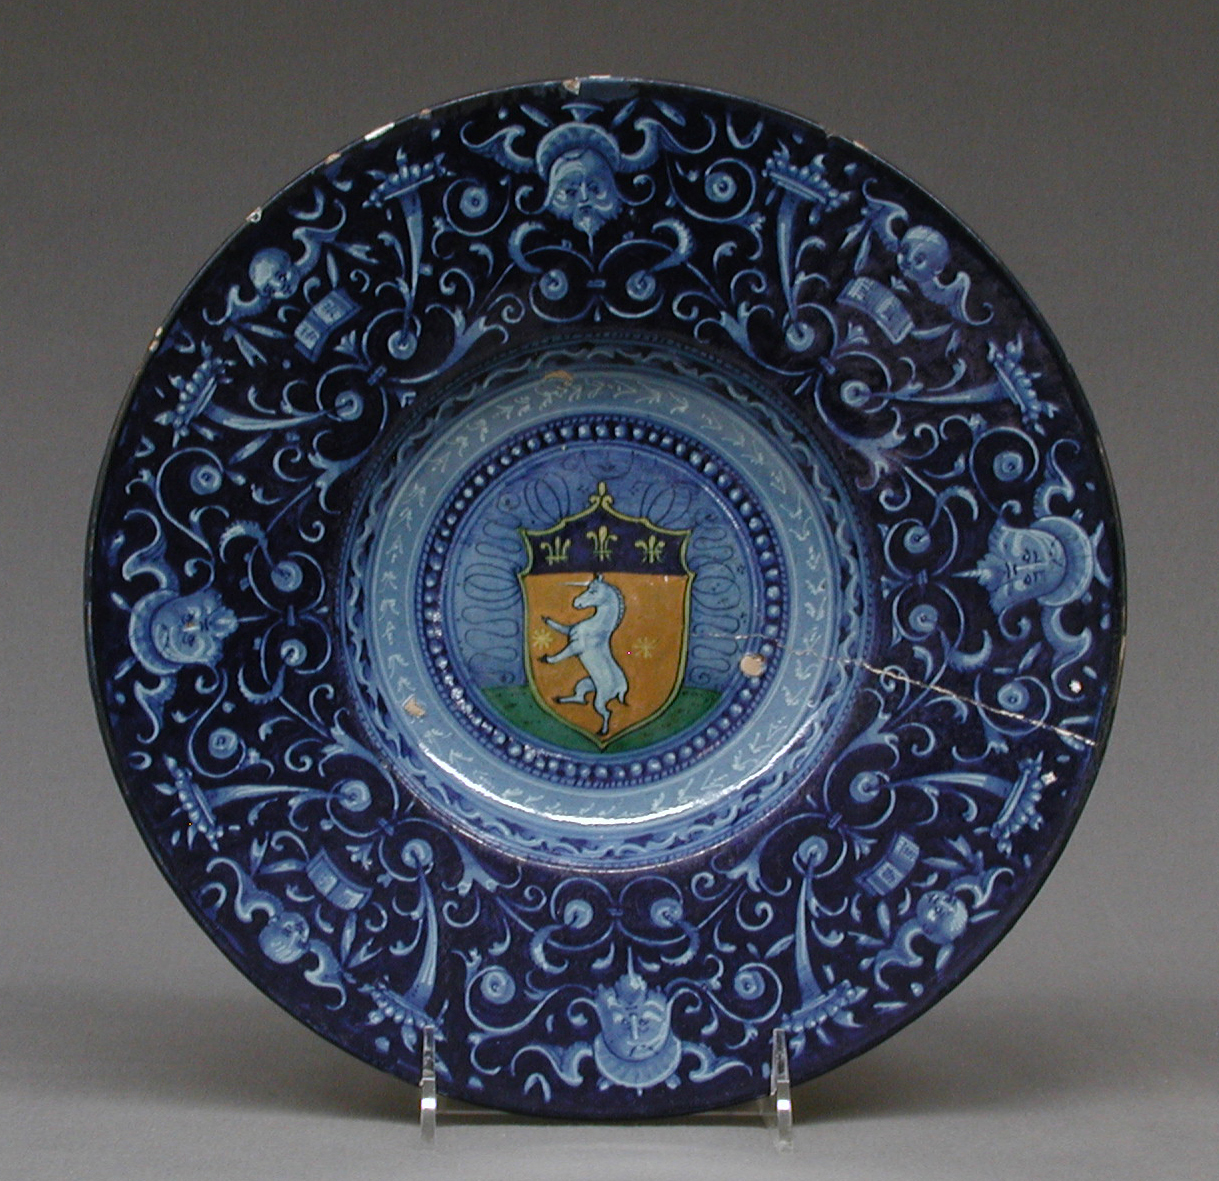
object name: plate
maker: casa pirota manufactory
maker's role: maker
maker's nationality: italian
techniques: maiolica, glazing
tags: coat of arms